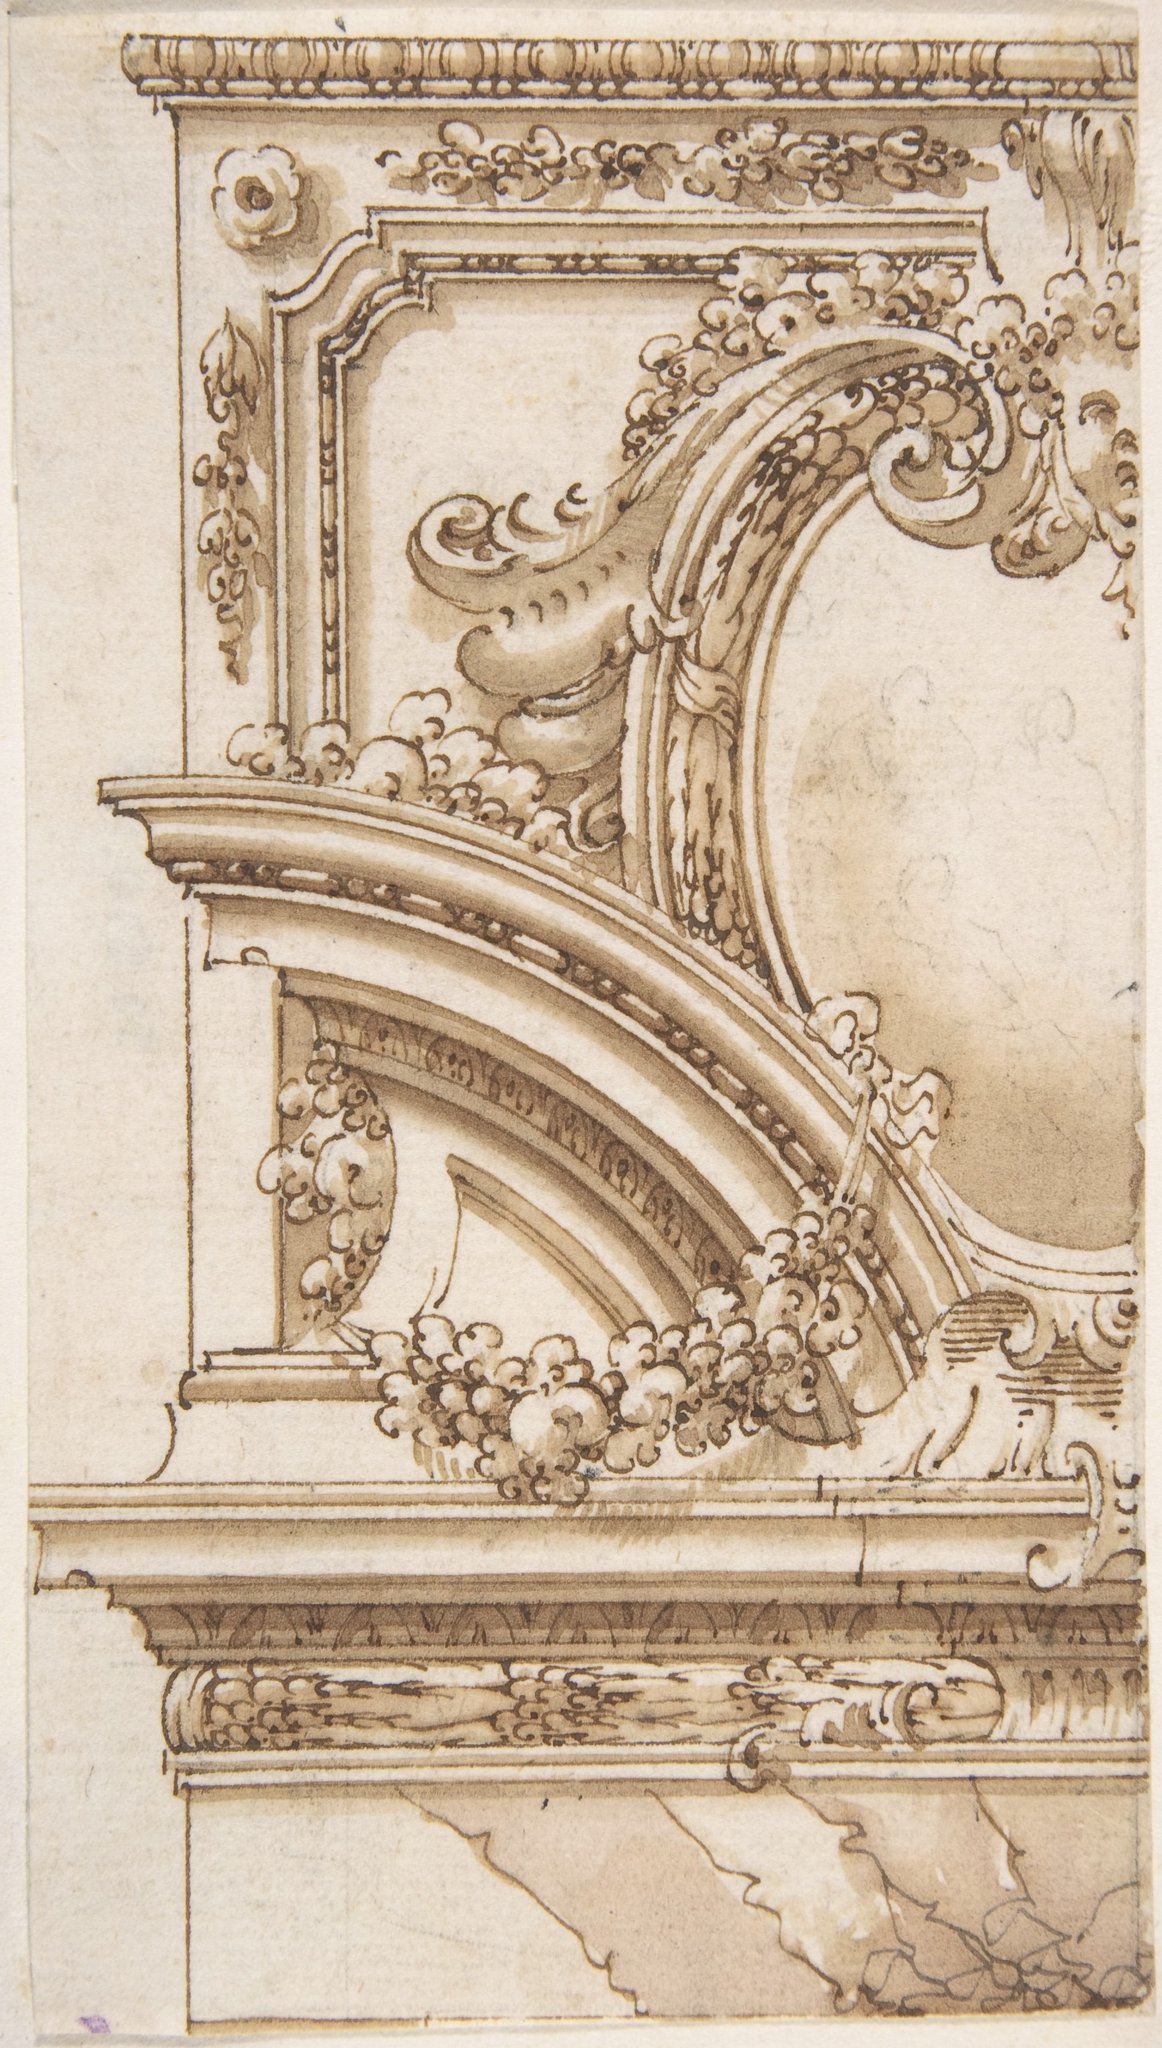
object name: drawing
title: Designs for an Overdoor Decoration (recto); Various Sketches (verso)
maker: anonymous, italian, bolognese, 18th century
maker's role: artist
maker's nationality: italian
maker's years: 1700-1800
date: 1740-1760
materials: chalk, ink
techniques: brush, pen, wash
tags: ornament